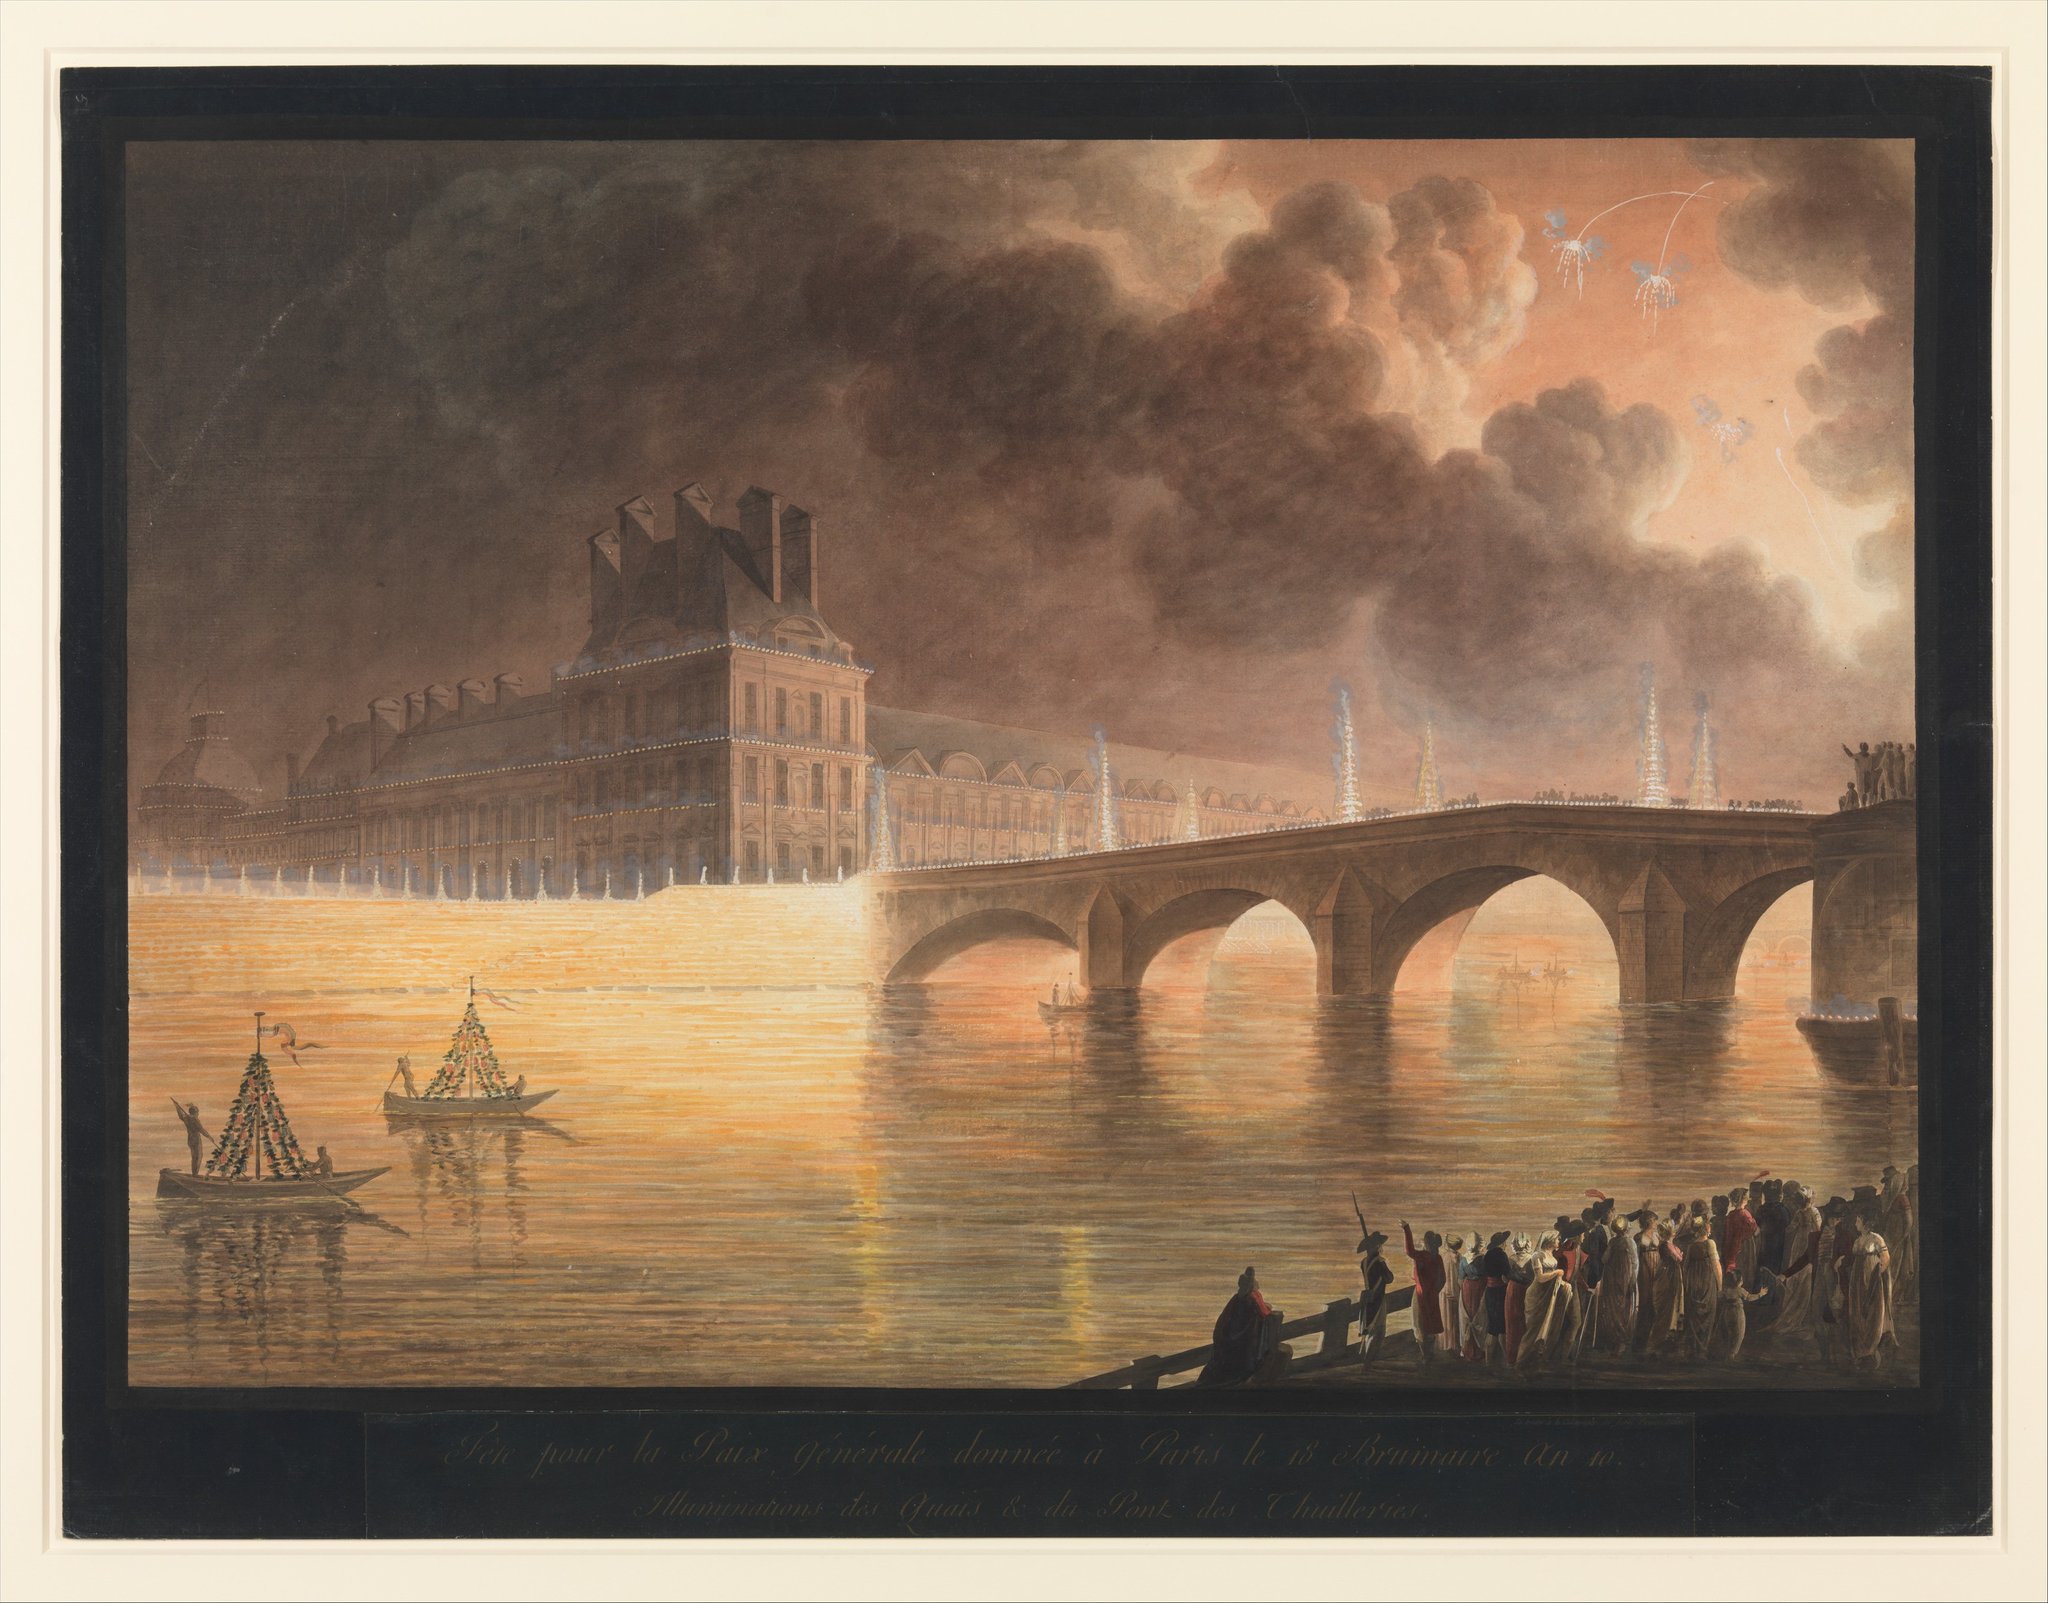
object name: print ornament architecture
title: Fête pour la Paix Générale donnée à Paris le 18 Brumaire. Pont Royal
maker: francesco piranesi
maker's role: artist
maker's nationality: italian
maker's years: 1758-1810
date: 1801-1802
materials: gold, gouache, ink, watercolor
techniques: engraving, printing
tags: buildings,bridges,fireworks,rivers,boats